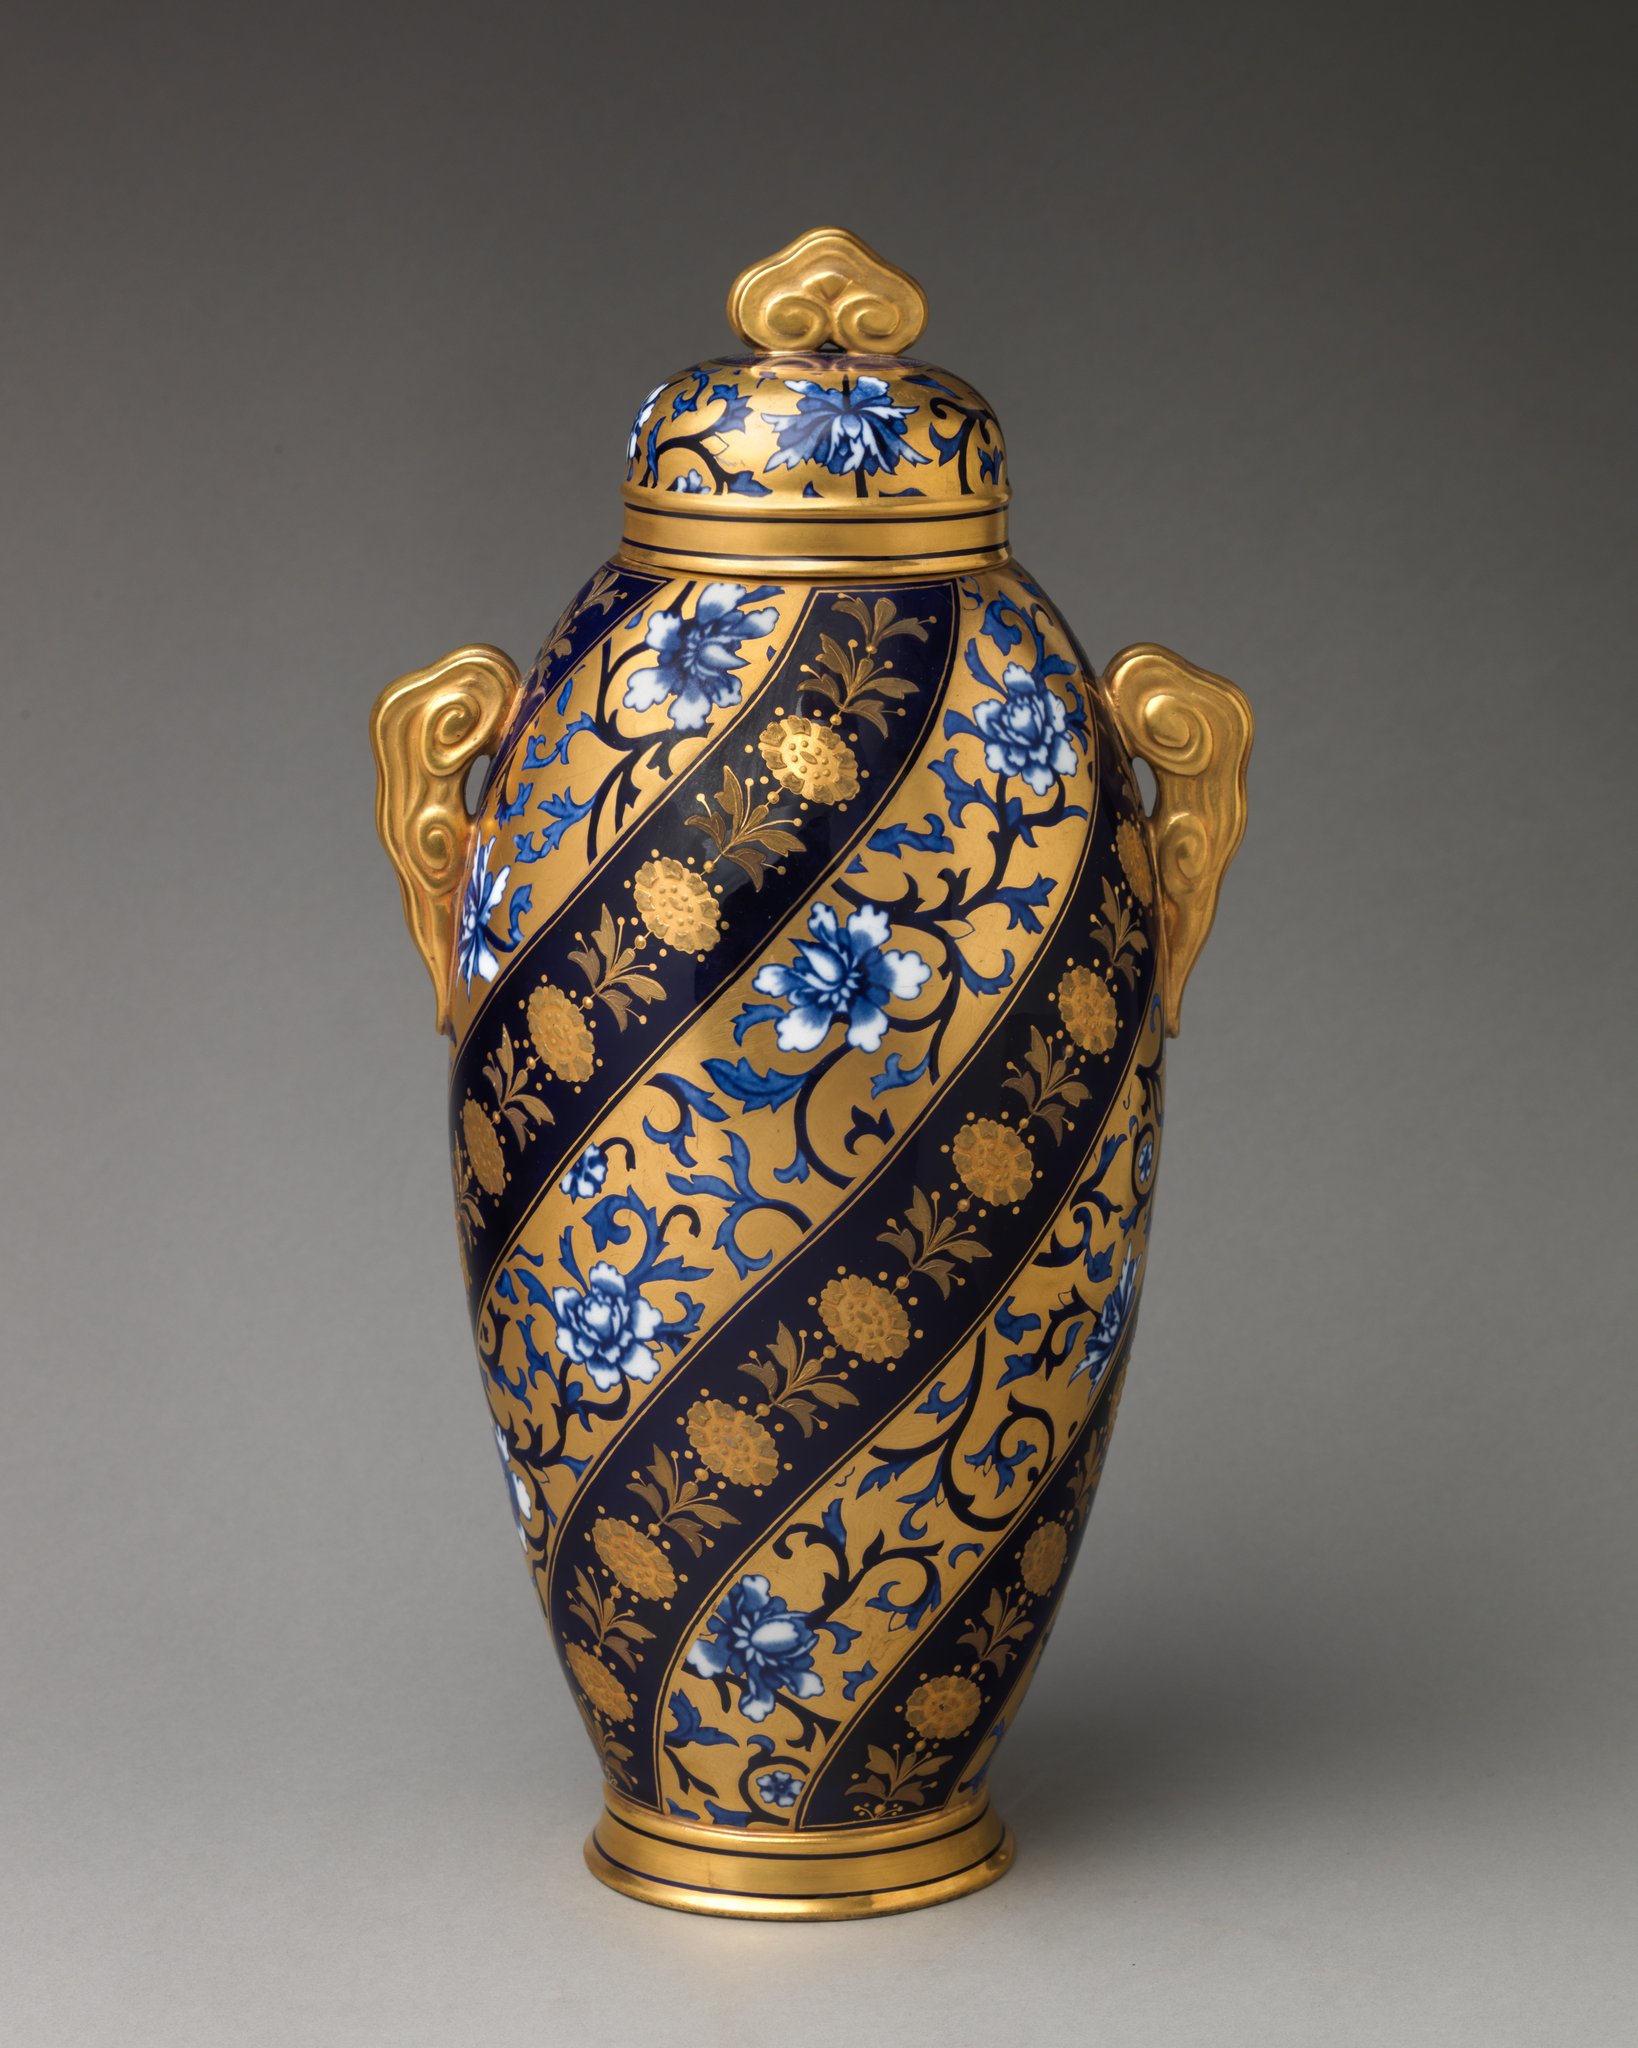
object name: urn with lid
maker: coalport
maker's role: maker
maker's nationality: british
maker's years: 1794-1926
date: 1881-1891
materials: porcelain